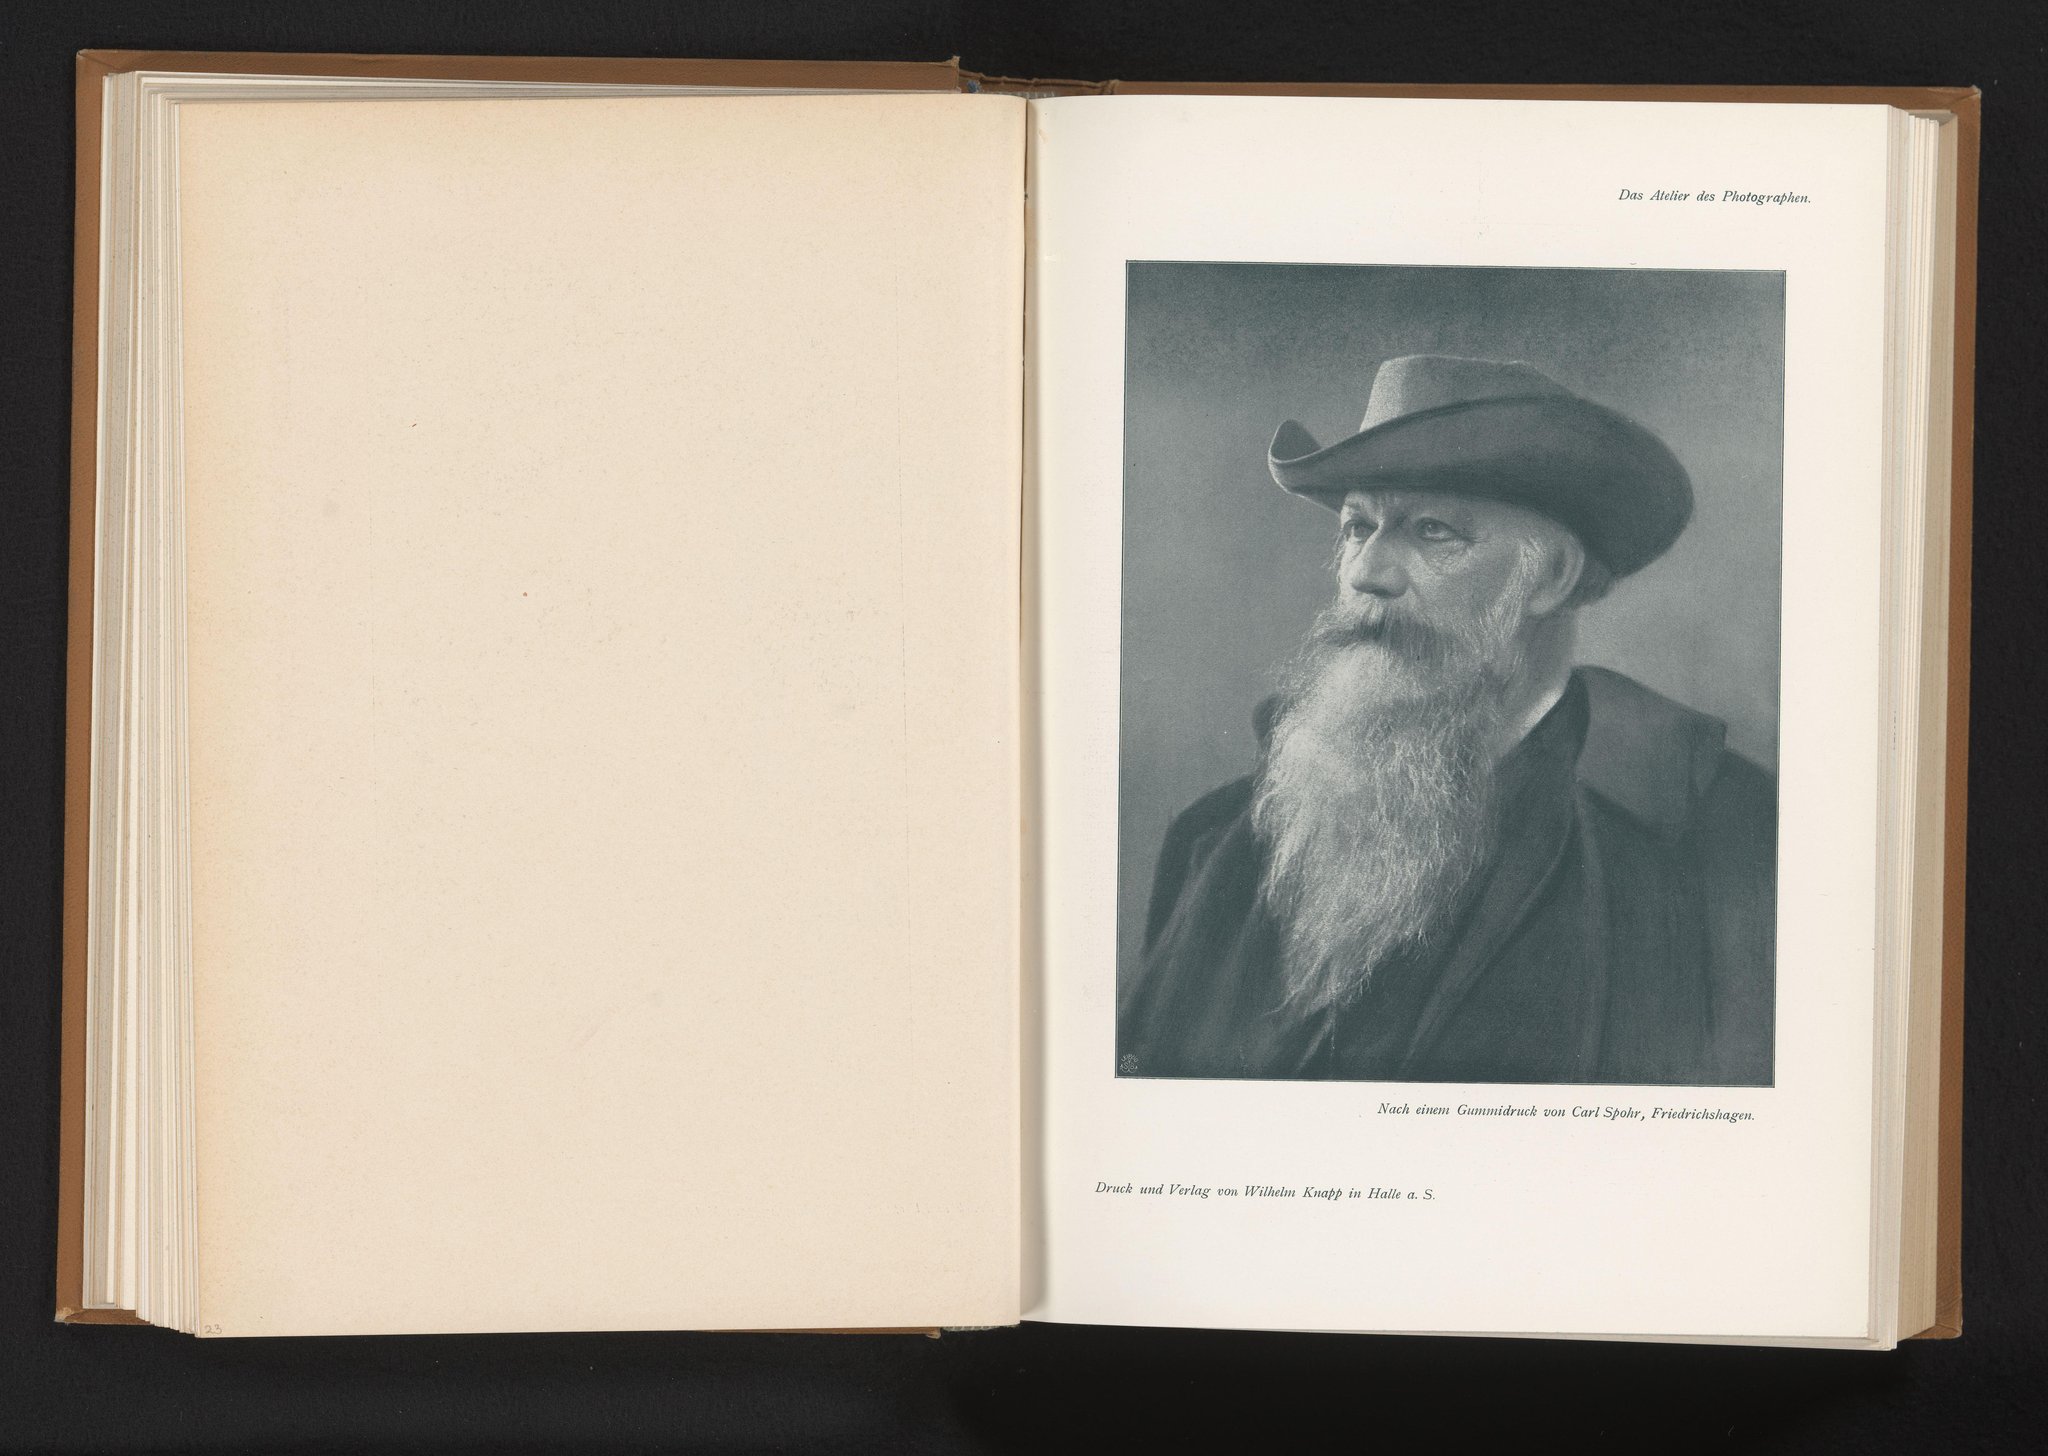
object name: photomechanical print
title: Portret van een onbekende man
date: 1895-1900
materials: paper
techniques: autotype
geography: friedrichshagen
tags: historical persons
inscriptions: monogram: ‘LEIPZIG/ S G’, inscription: ‘Das Atelier des Photographen.’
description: Prent op derde ongenummerde pagina na pagina 88.